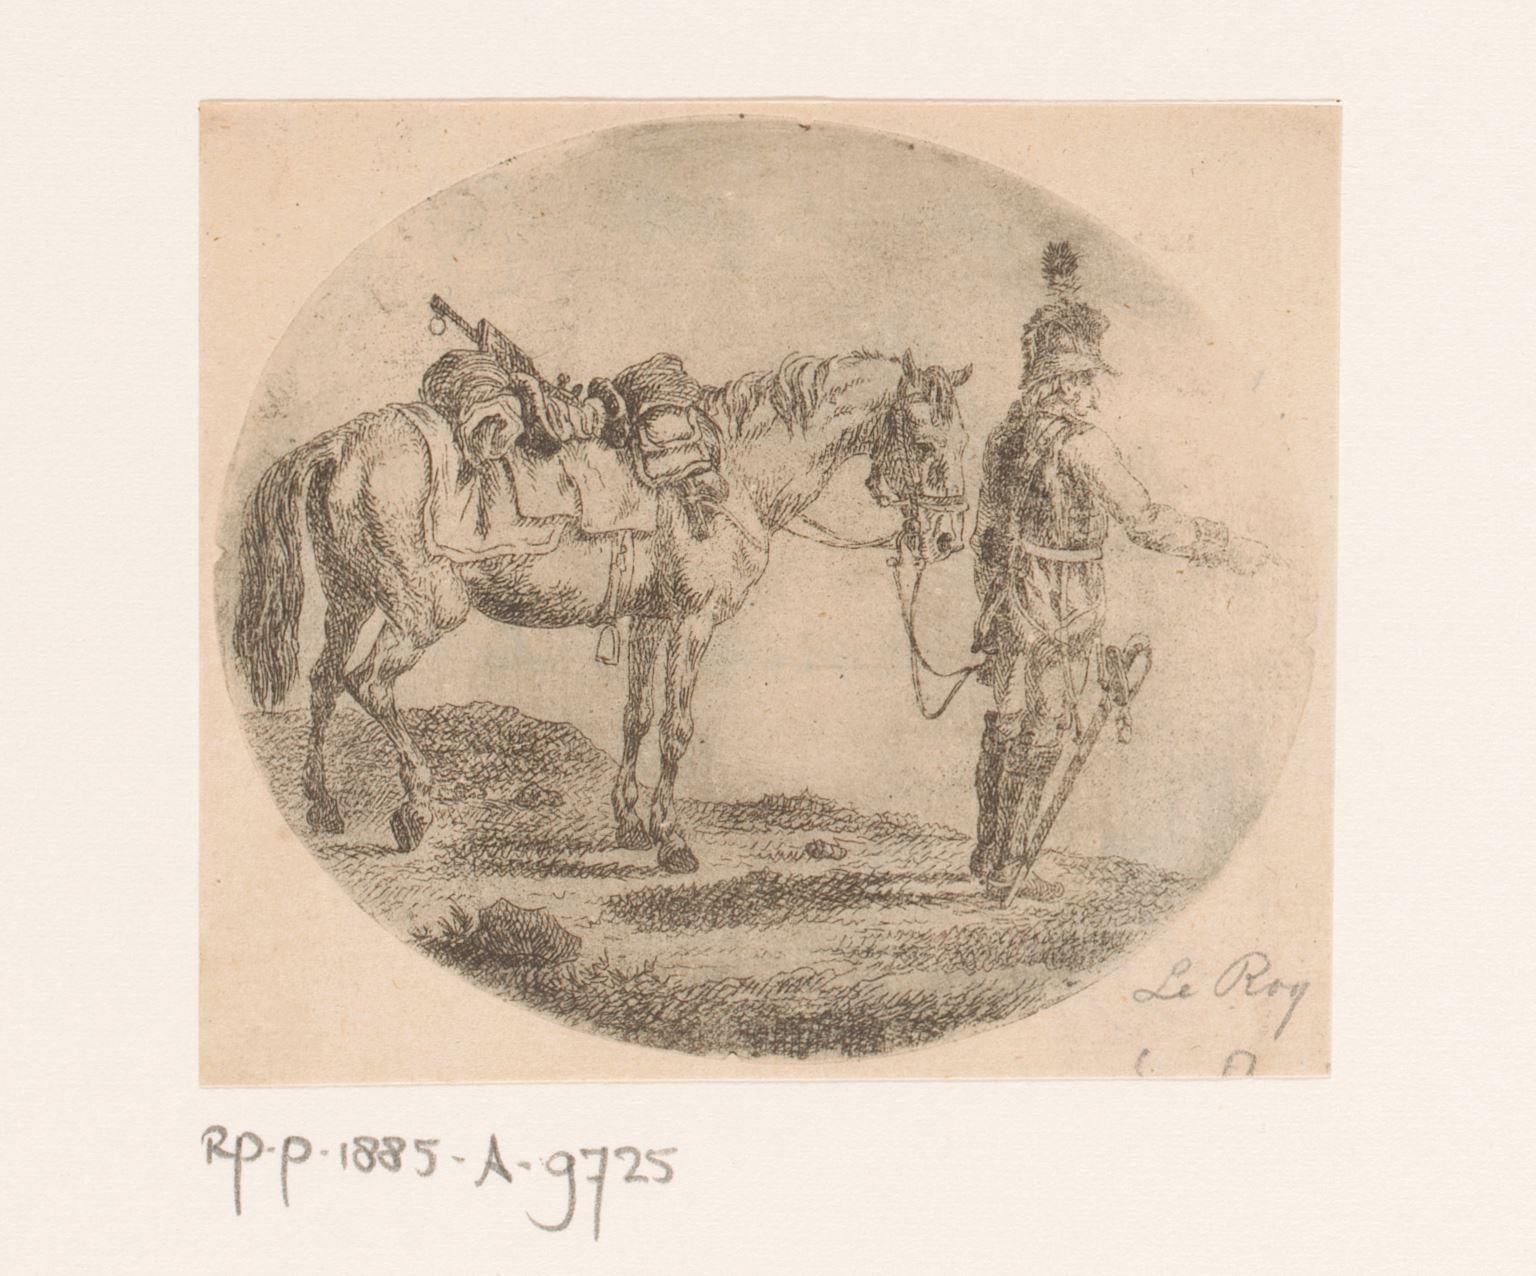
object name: print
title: Afgestegen cavalerist met de teugels in de hand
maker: pierre-françois le roy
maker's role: draughtsman, painter, print maker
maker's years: 1771-1862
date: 1794-1862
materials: paper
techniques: etching, intaglio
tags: private soldier (+ cavalry, horsemen)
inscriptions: collector's mark: Lugt 2228